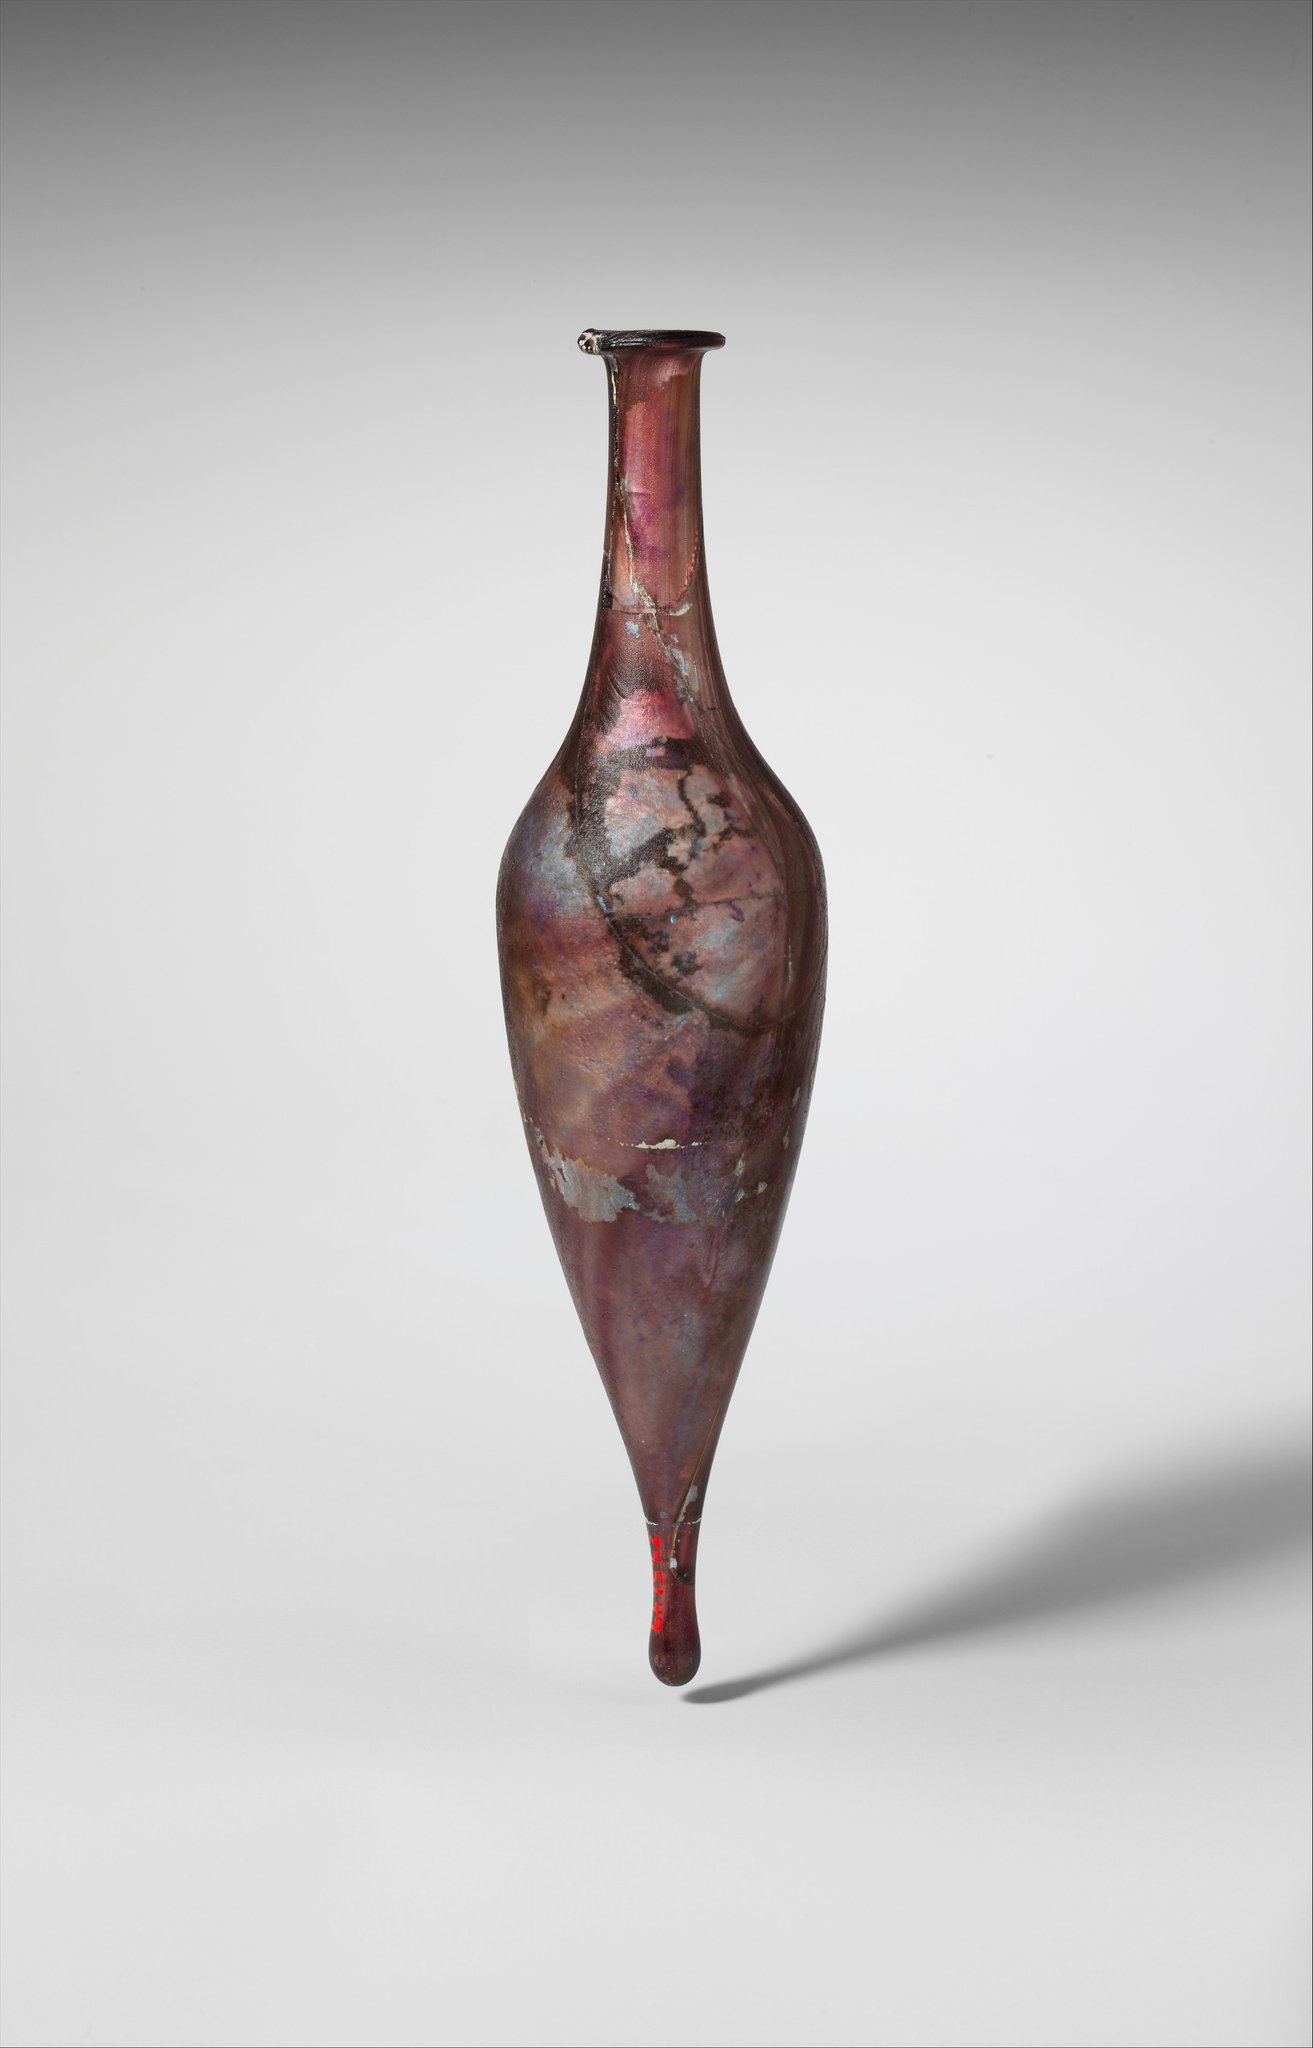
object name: bottle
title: Glass perfume bottle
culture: roman, cypriot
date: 1-100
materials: glass